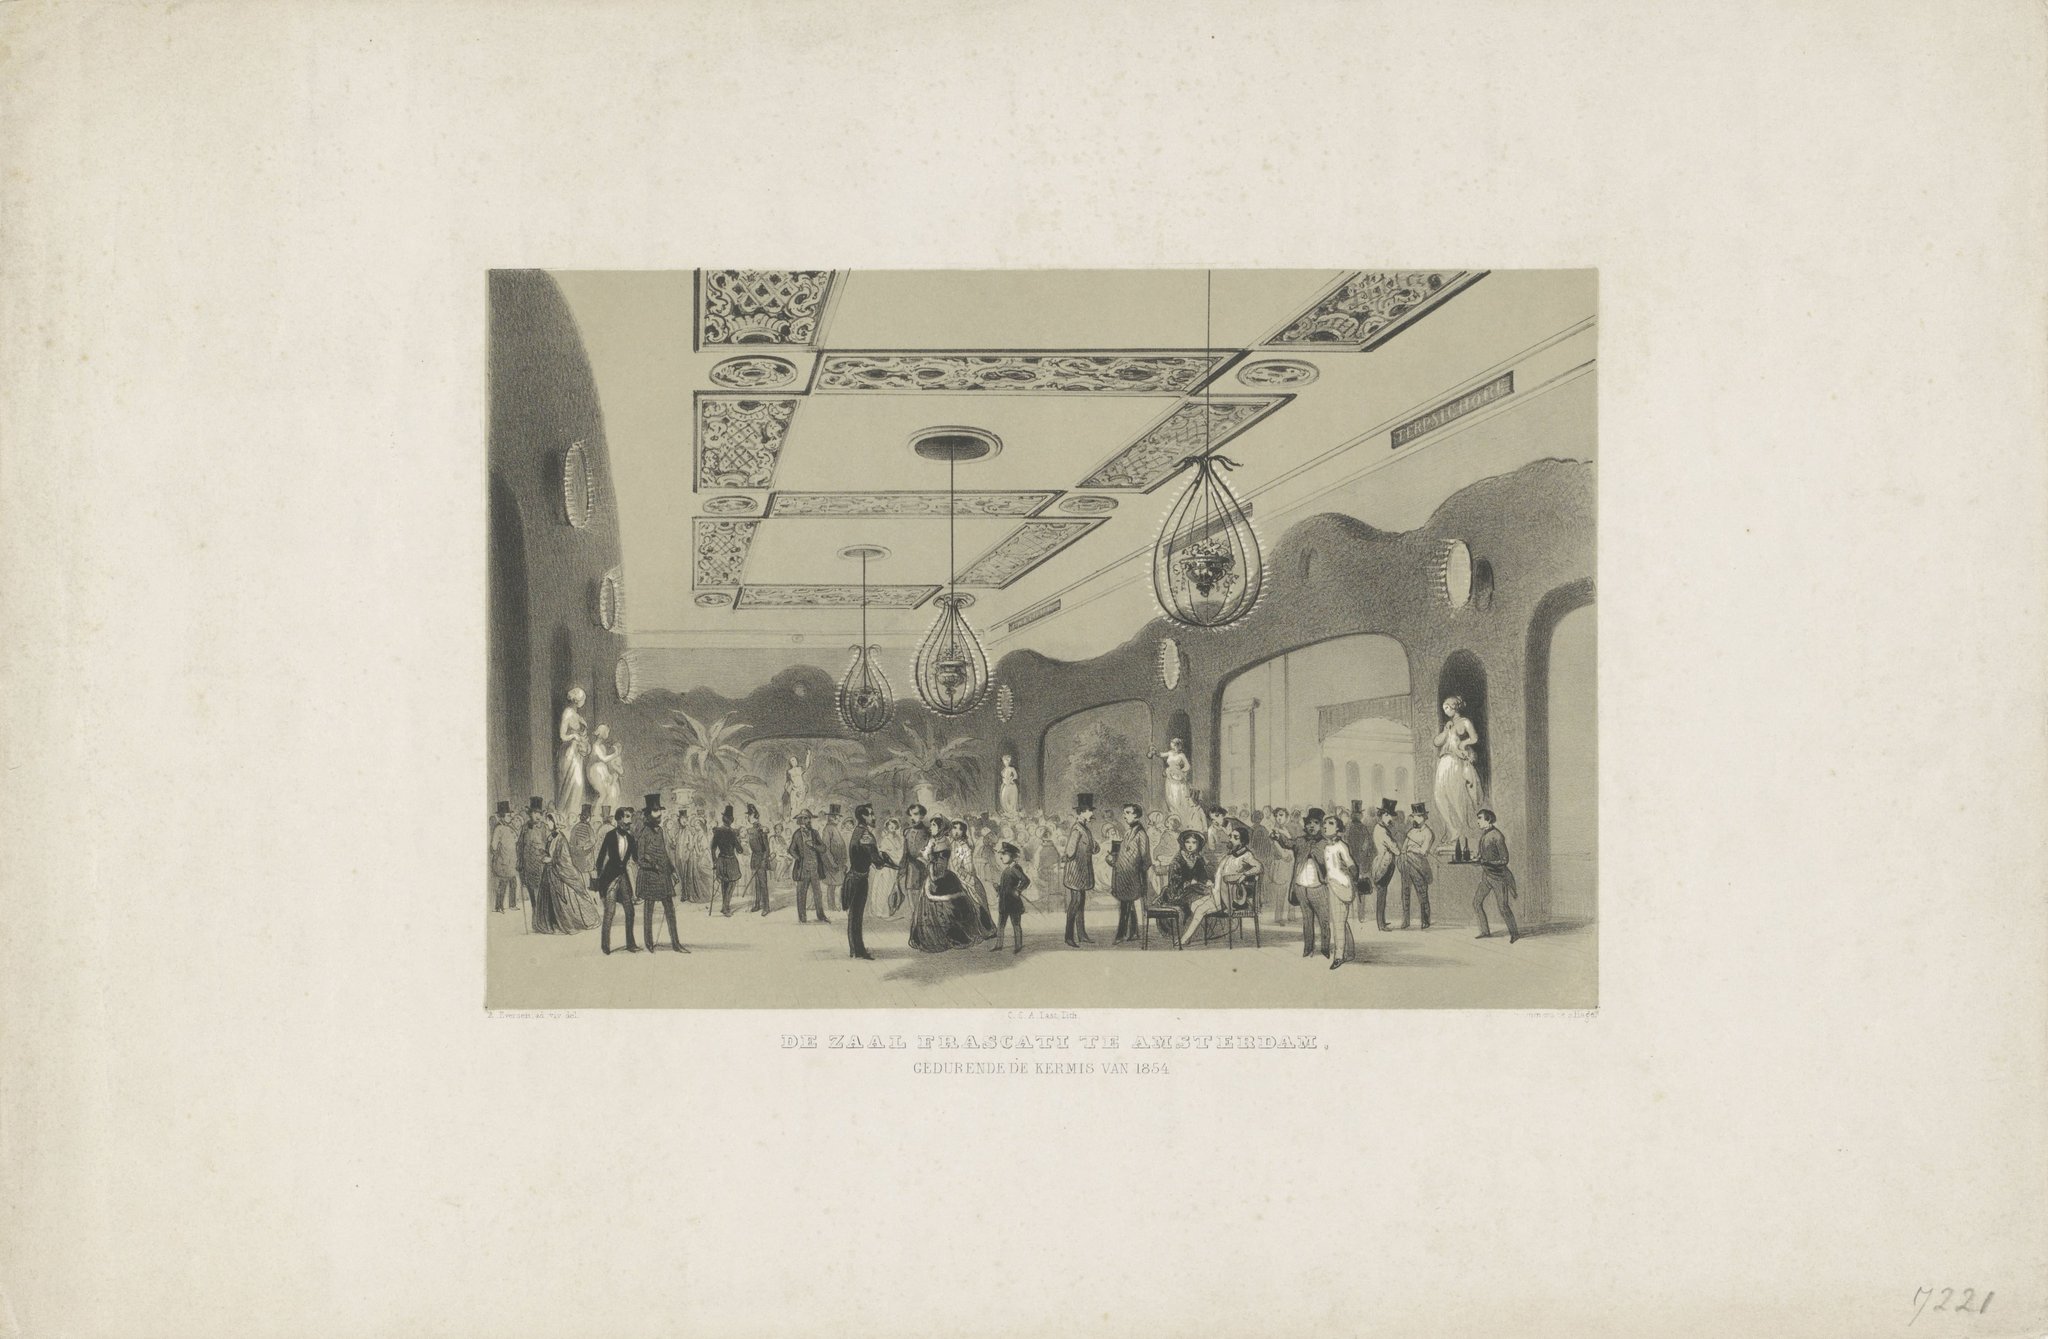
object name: print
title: De zaal Frascati te Amsterdam, gedurende de kermis van 1854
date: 1854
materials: paper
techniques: tone lithography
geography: amsterdam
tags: club, meeting place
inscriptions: collector's mark: Lugt 2228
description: Gezicht in de zaal van Frascati te Amsterdam tijdens de kermis van september 1854.